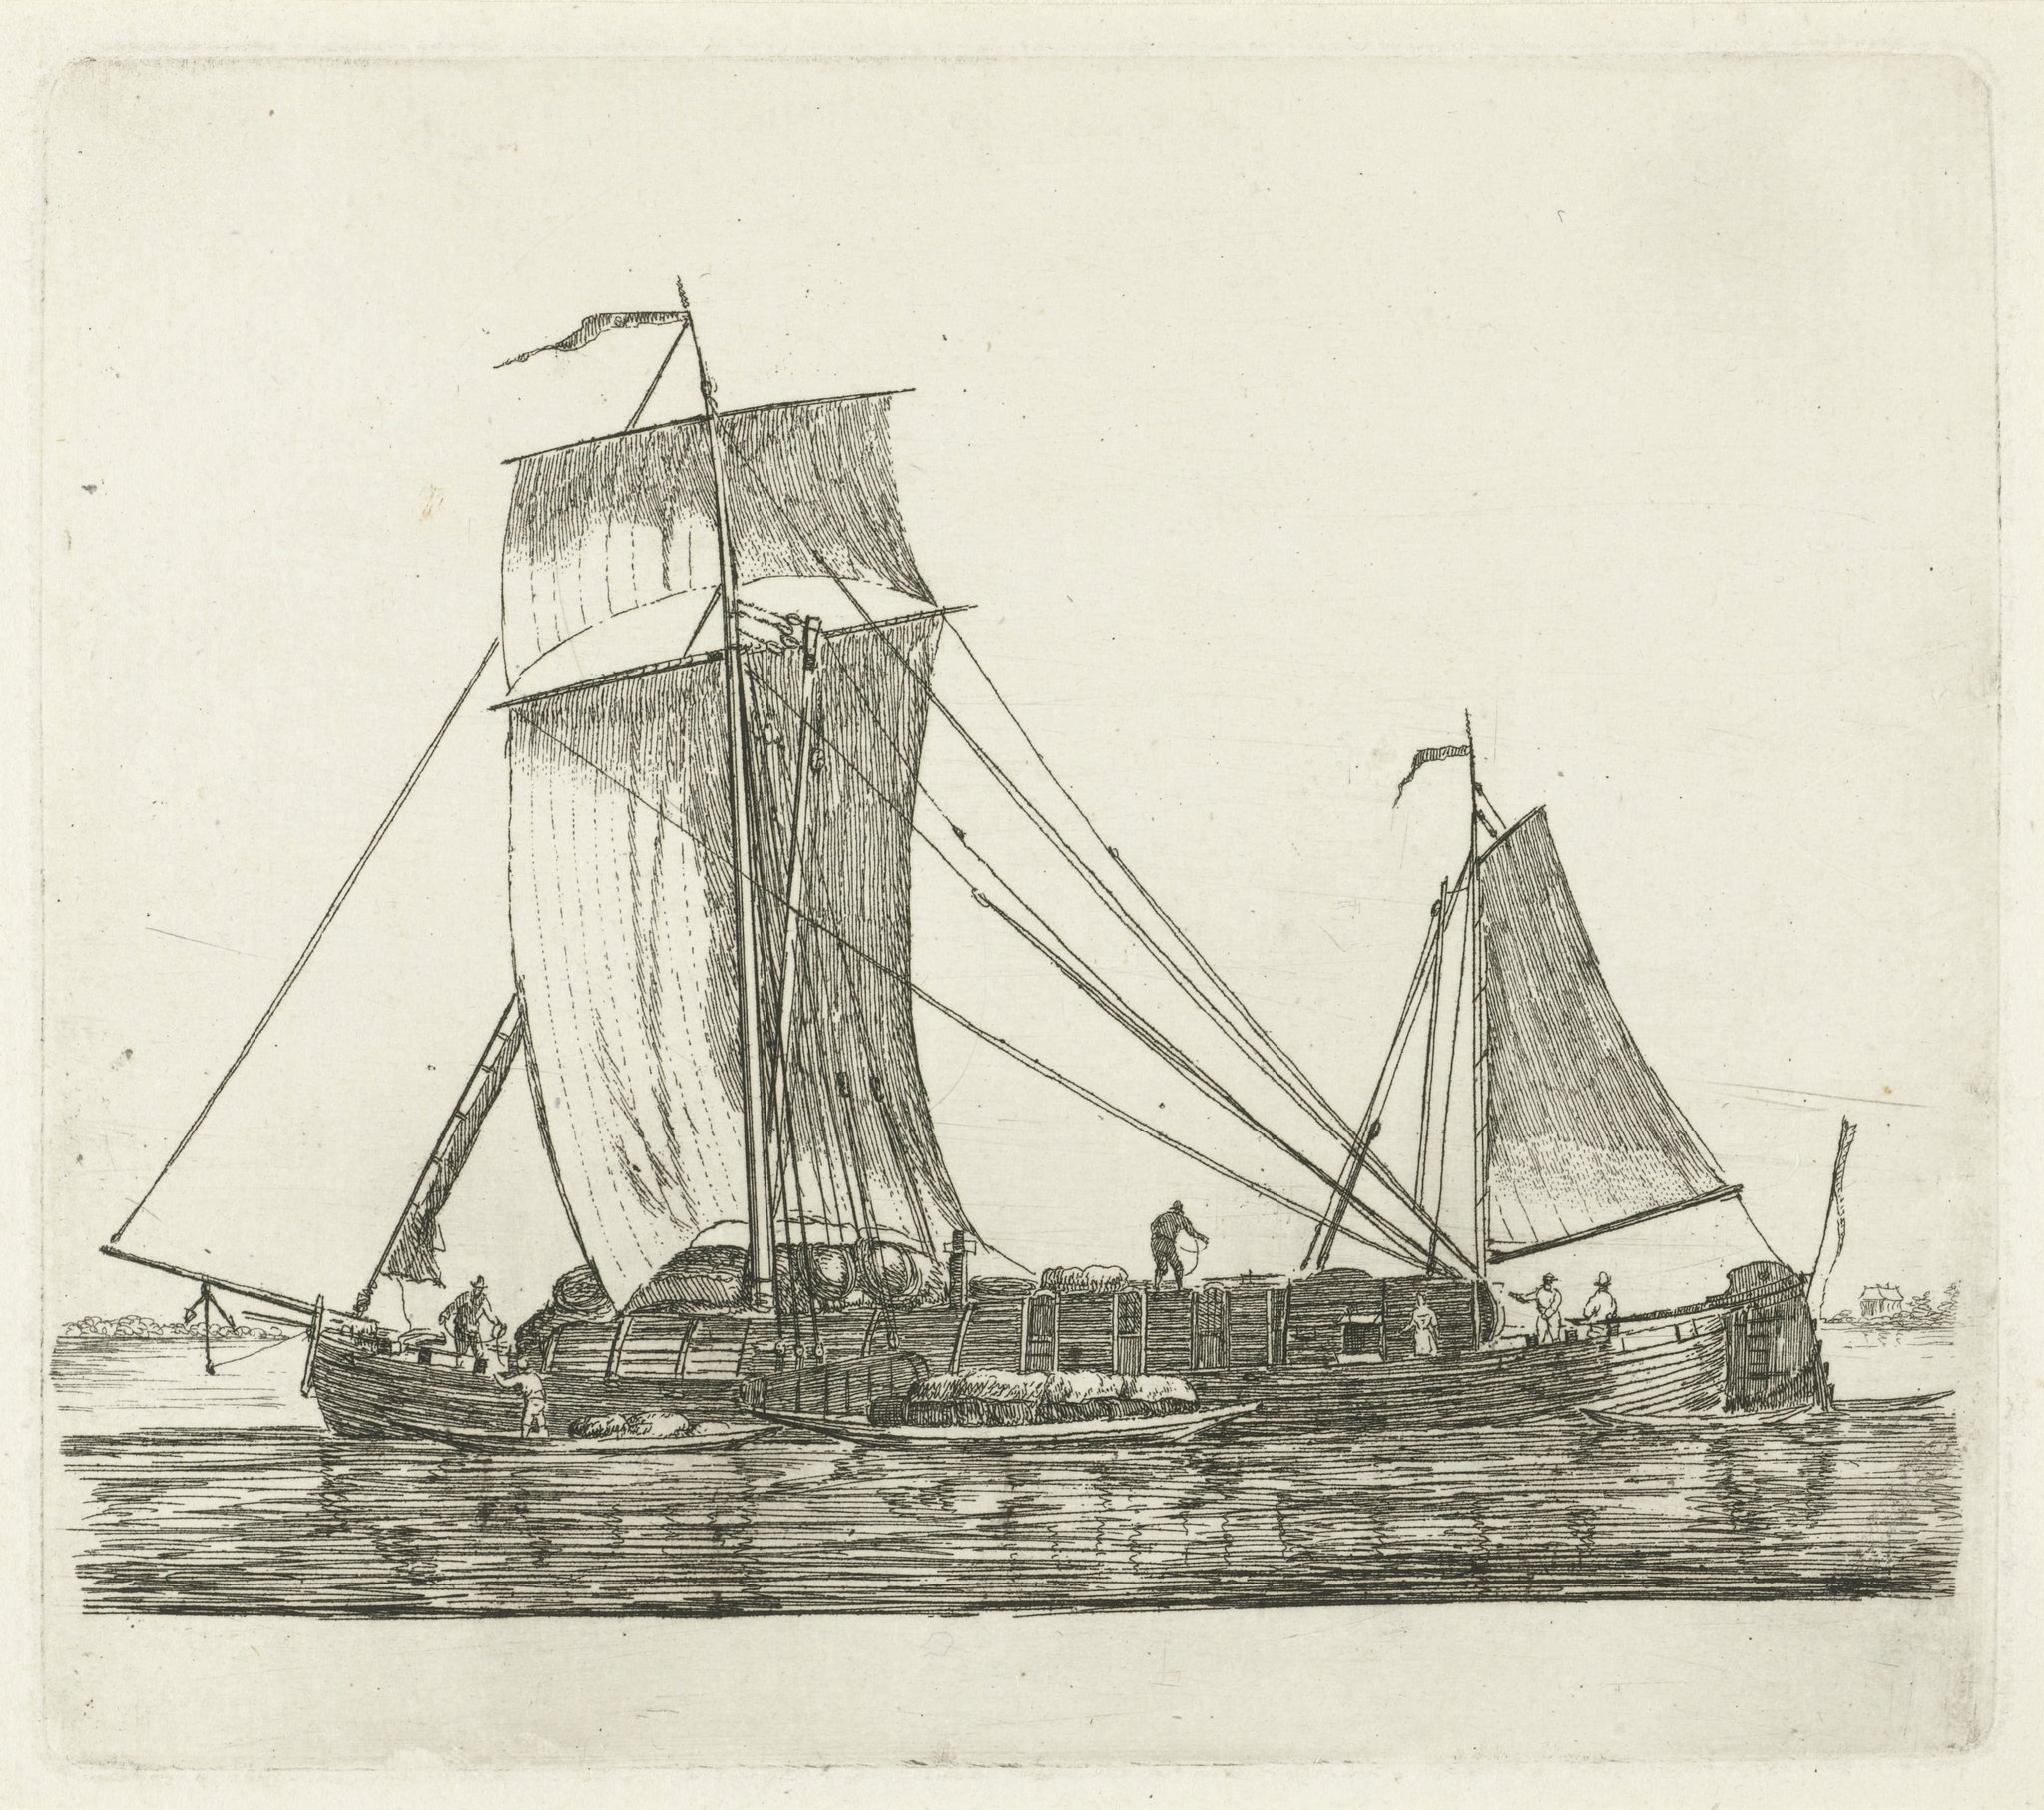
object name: print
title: Verschillende schepen serie F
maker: gerrit groenewegen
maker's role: draughtsman, print maker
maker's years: 1754-1826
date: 1791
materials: paper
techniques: etching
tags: ships (in general)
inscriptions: collector's mark: Lugt 2228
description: Een Keulenaar of Samoreus vanaf de zijkant gezien. Enkele figuren zijn bezig om goederen van de Keulenaar op twee kleinere boten te laden. Deze prent maakt deel uit van een serie van twaalf prenten met verschillende zeilschepen.